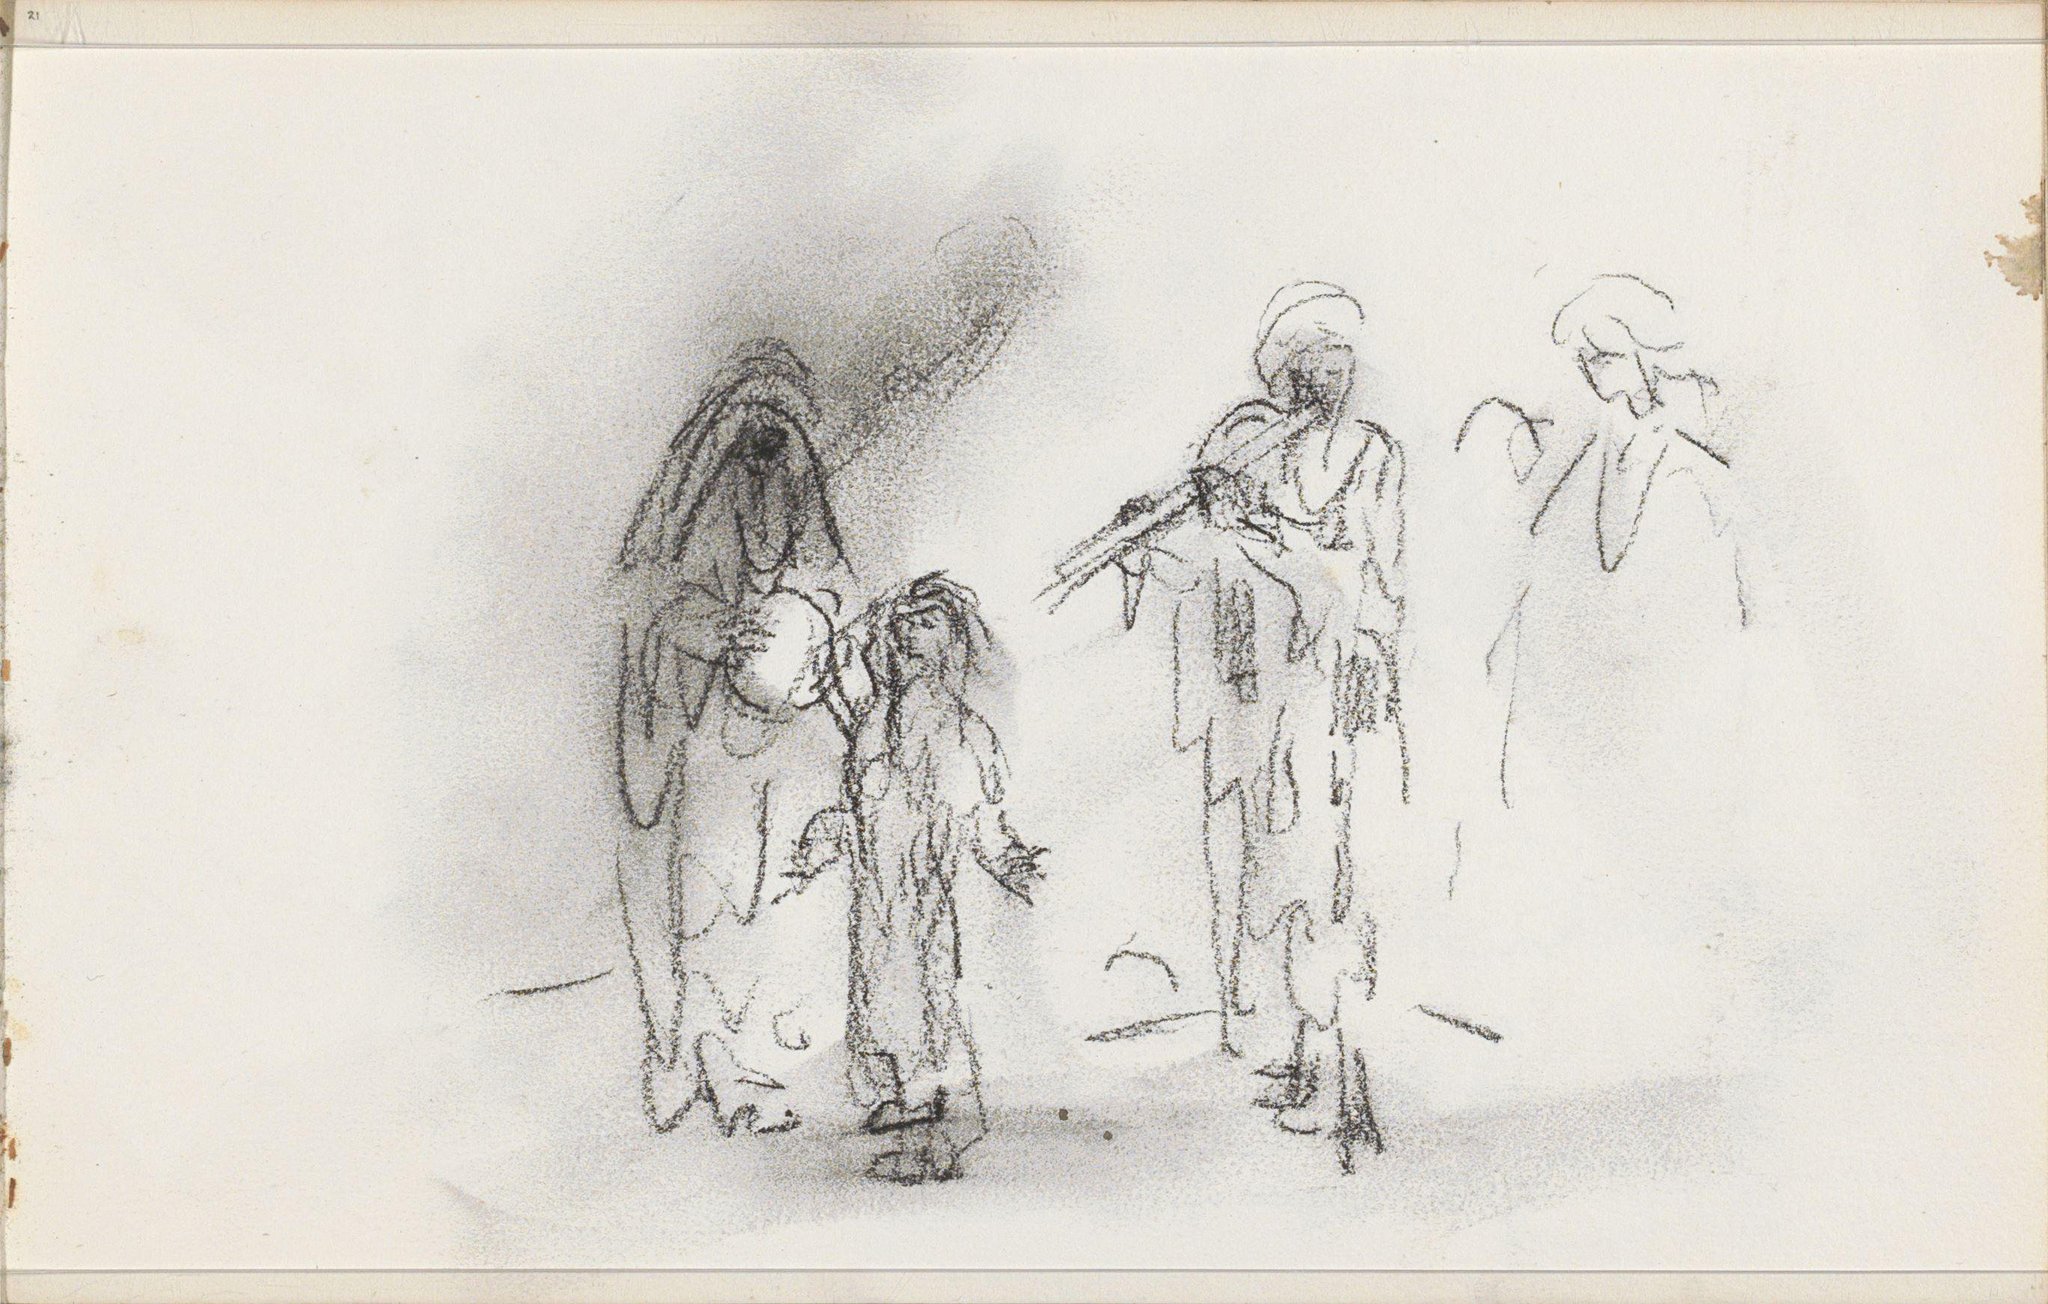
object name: sketchbook leaf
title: Musicerende Egyptenaren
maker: marius bauer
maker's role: draughtsman, print maker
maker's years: 1867-1932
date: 1919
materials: chalk, paper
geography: egypt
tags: making music; musician with instrument, africans, tambourine, flute, aulos, tibia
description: Eén man speelt een fluit, een ander heeft een tamboerijn in de handen. Pagina 21 uit een schetsboek met 18 bladen.